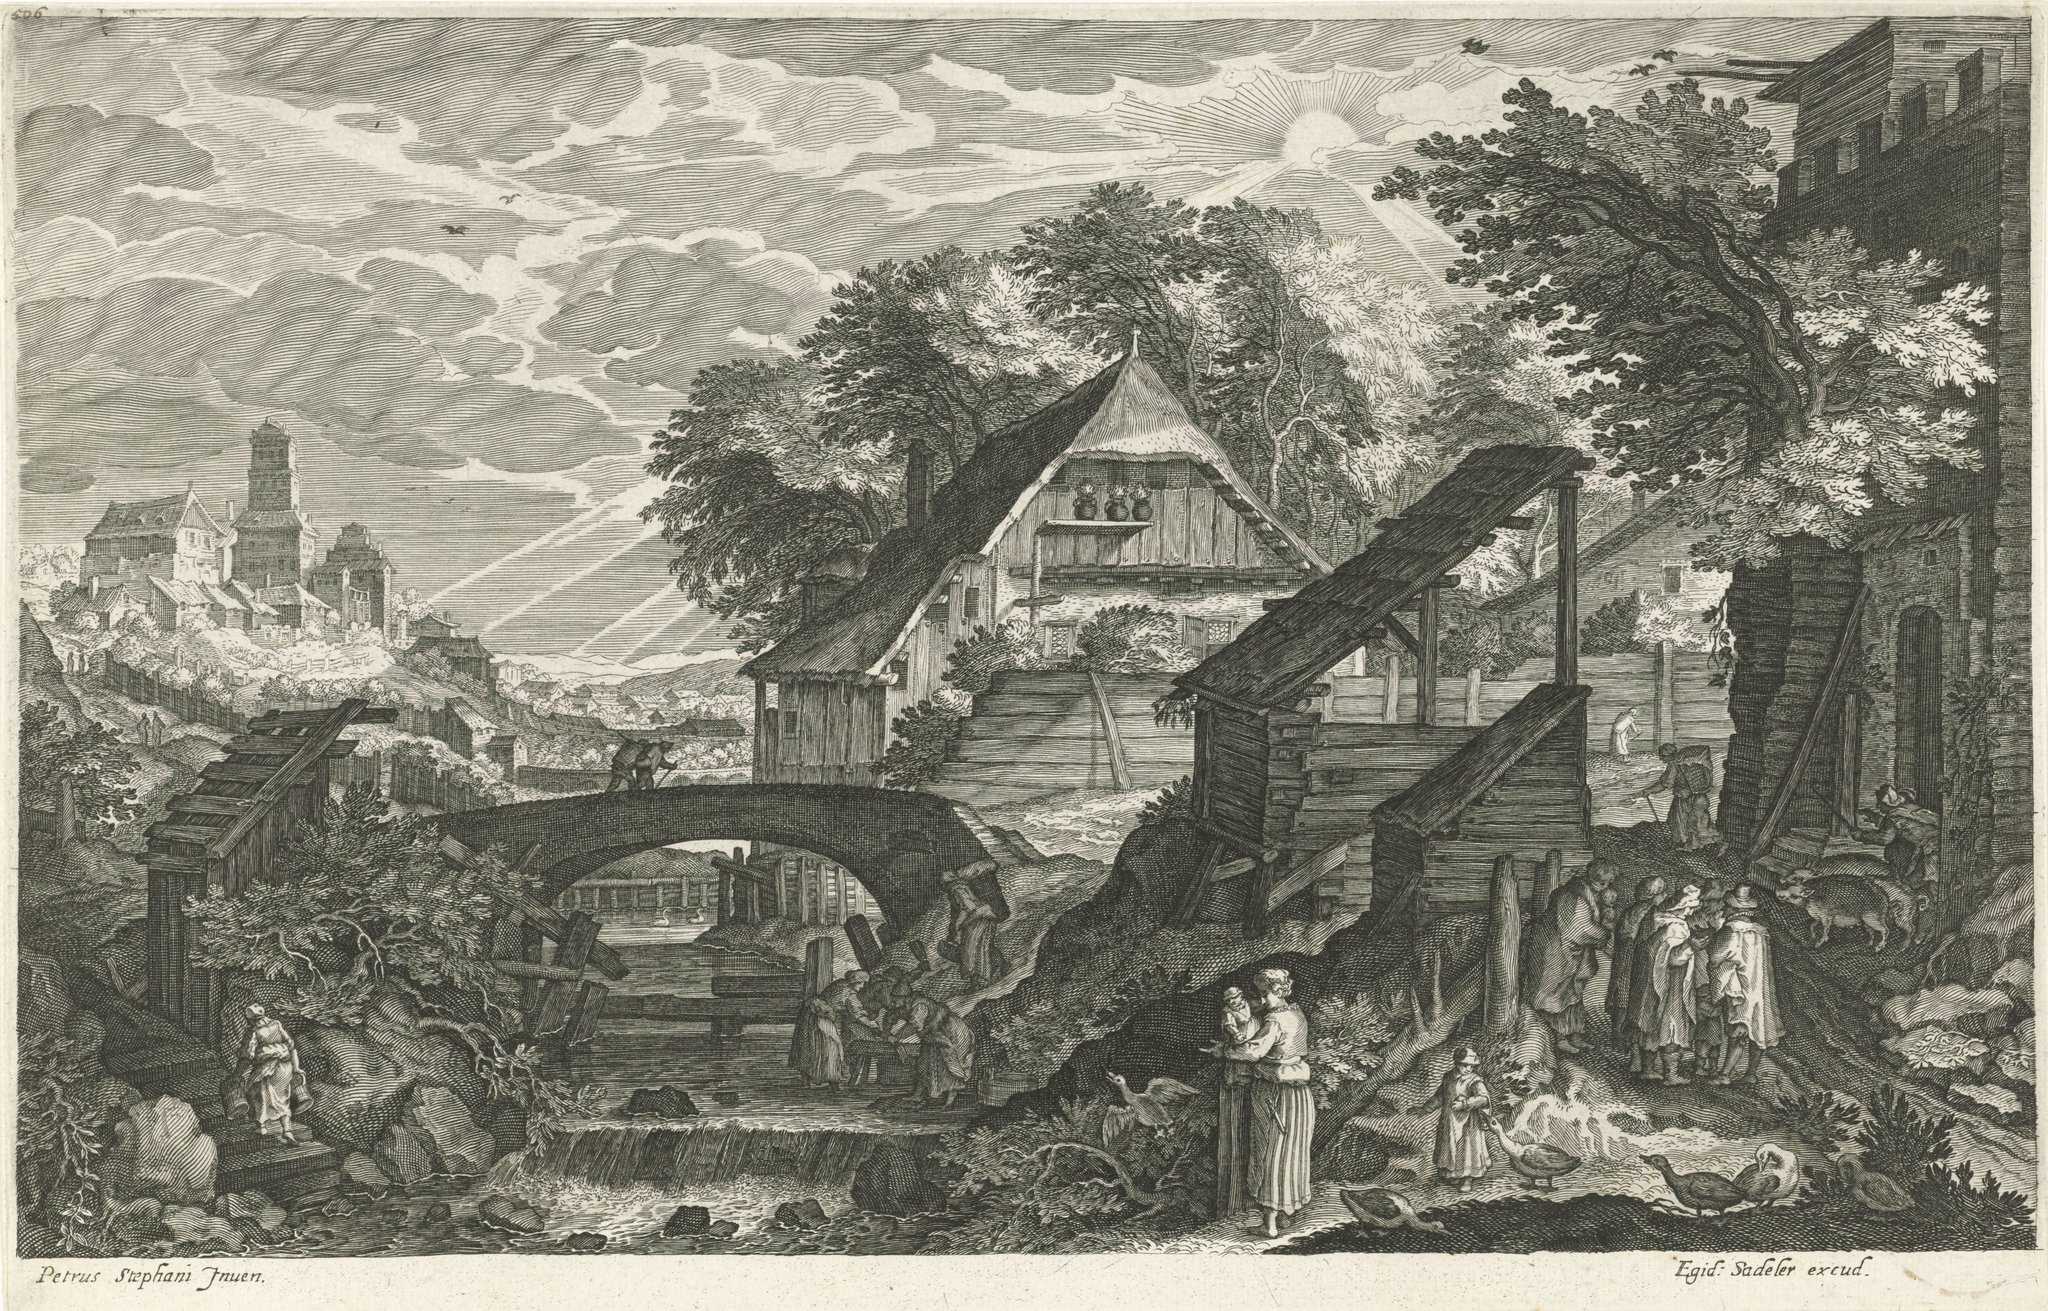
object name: print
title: Acht landschappen in Bohemen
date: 1597-1629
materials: paper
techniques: engraving, etching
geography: prague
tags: laundering, bridge in village across river, canal, etc. (+ city(-scape) with figures, staffage)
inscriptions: collector's mark: Lugt 240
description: Een rivier die door een dorp stroomt. Over de rivier een brug. Naast de rivier doen vrouwen de was. De tweede prent van een achtdelige reeks met landschappen in Bohemen